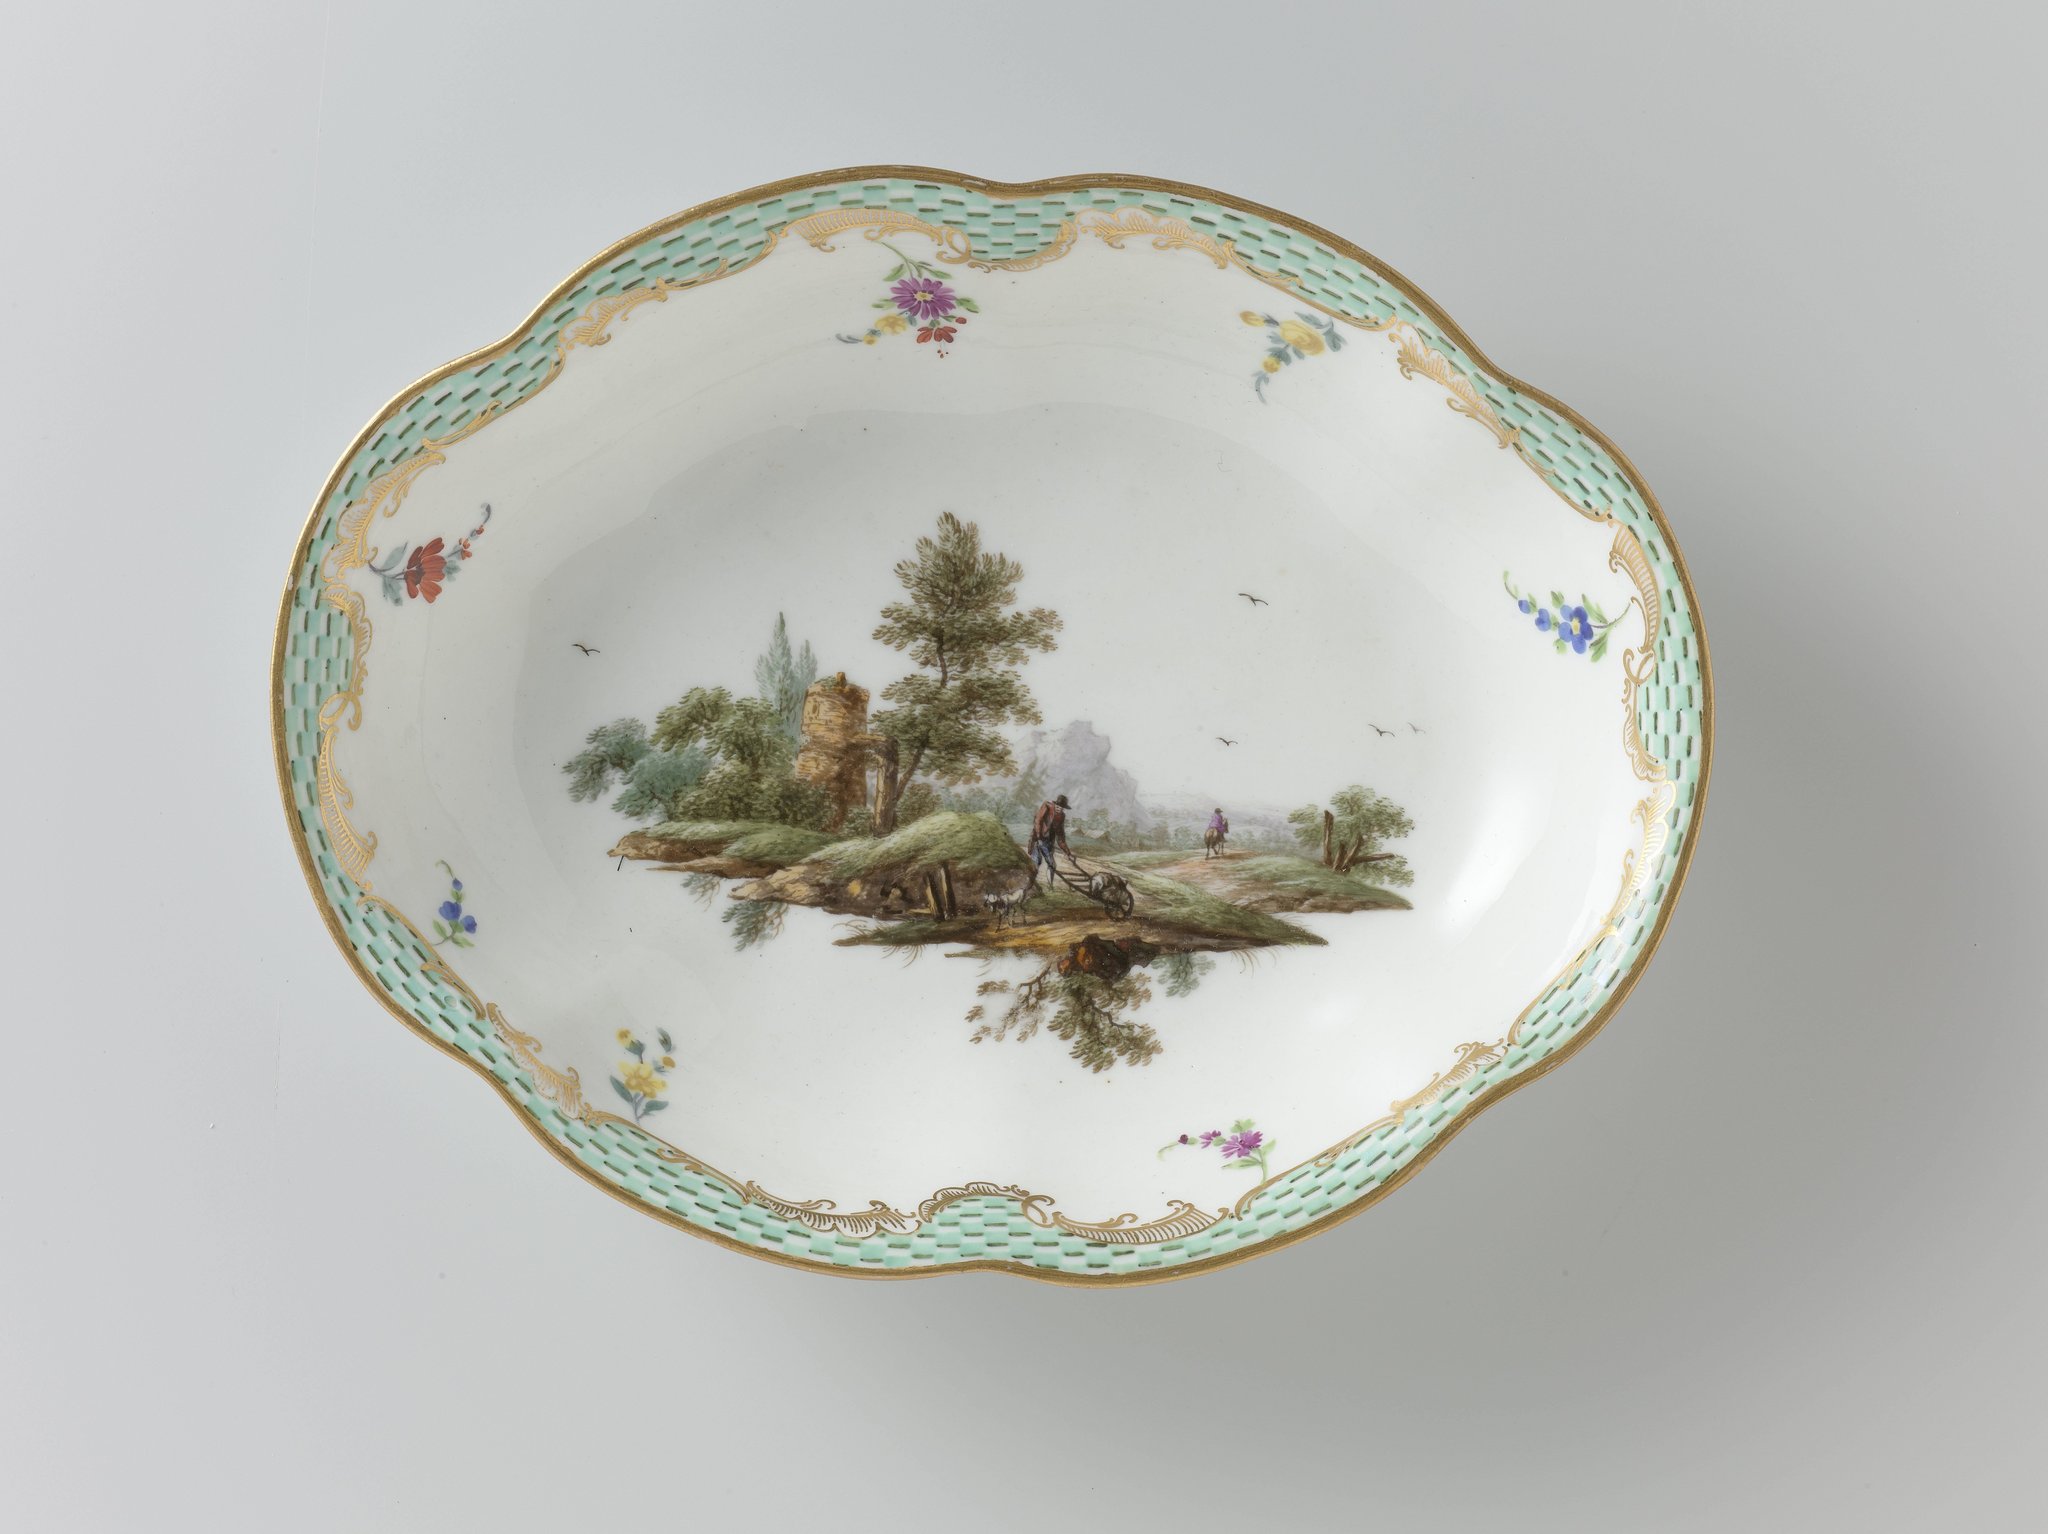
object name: eating drinking utensil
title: Pattipan, veelkleurig beschilderd met een landschap met figuren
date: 1777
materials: porcelain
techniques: painted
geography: meissen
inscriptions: mark, factory mark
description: Ovale pattipan met een geschulpte rand. De pattipan is beschilderd met landschappen waarin figuren en langs de rand een brede strook groen vlechtwerk. De pattipan is gemerkt.